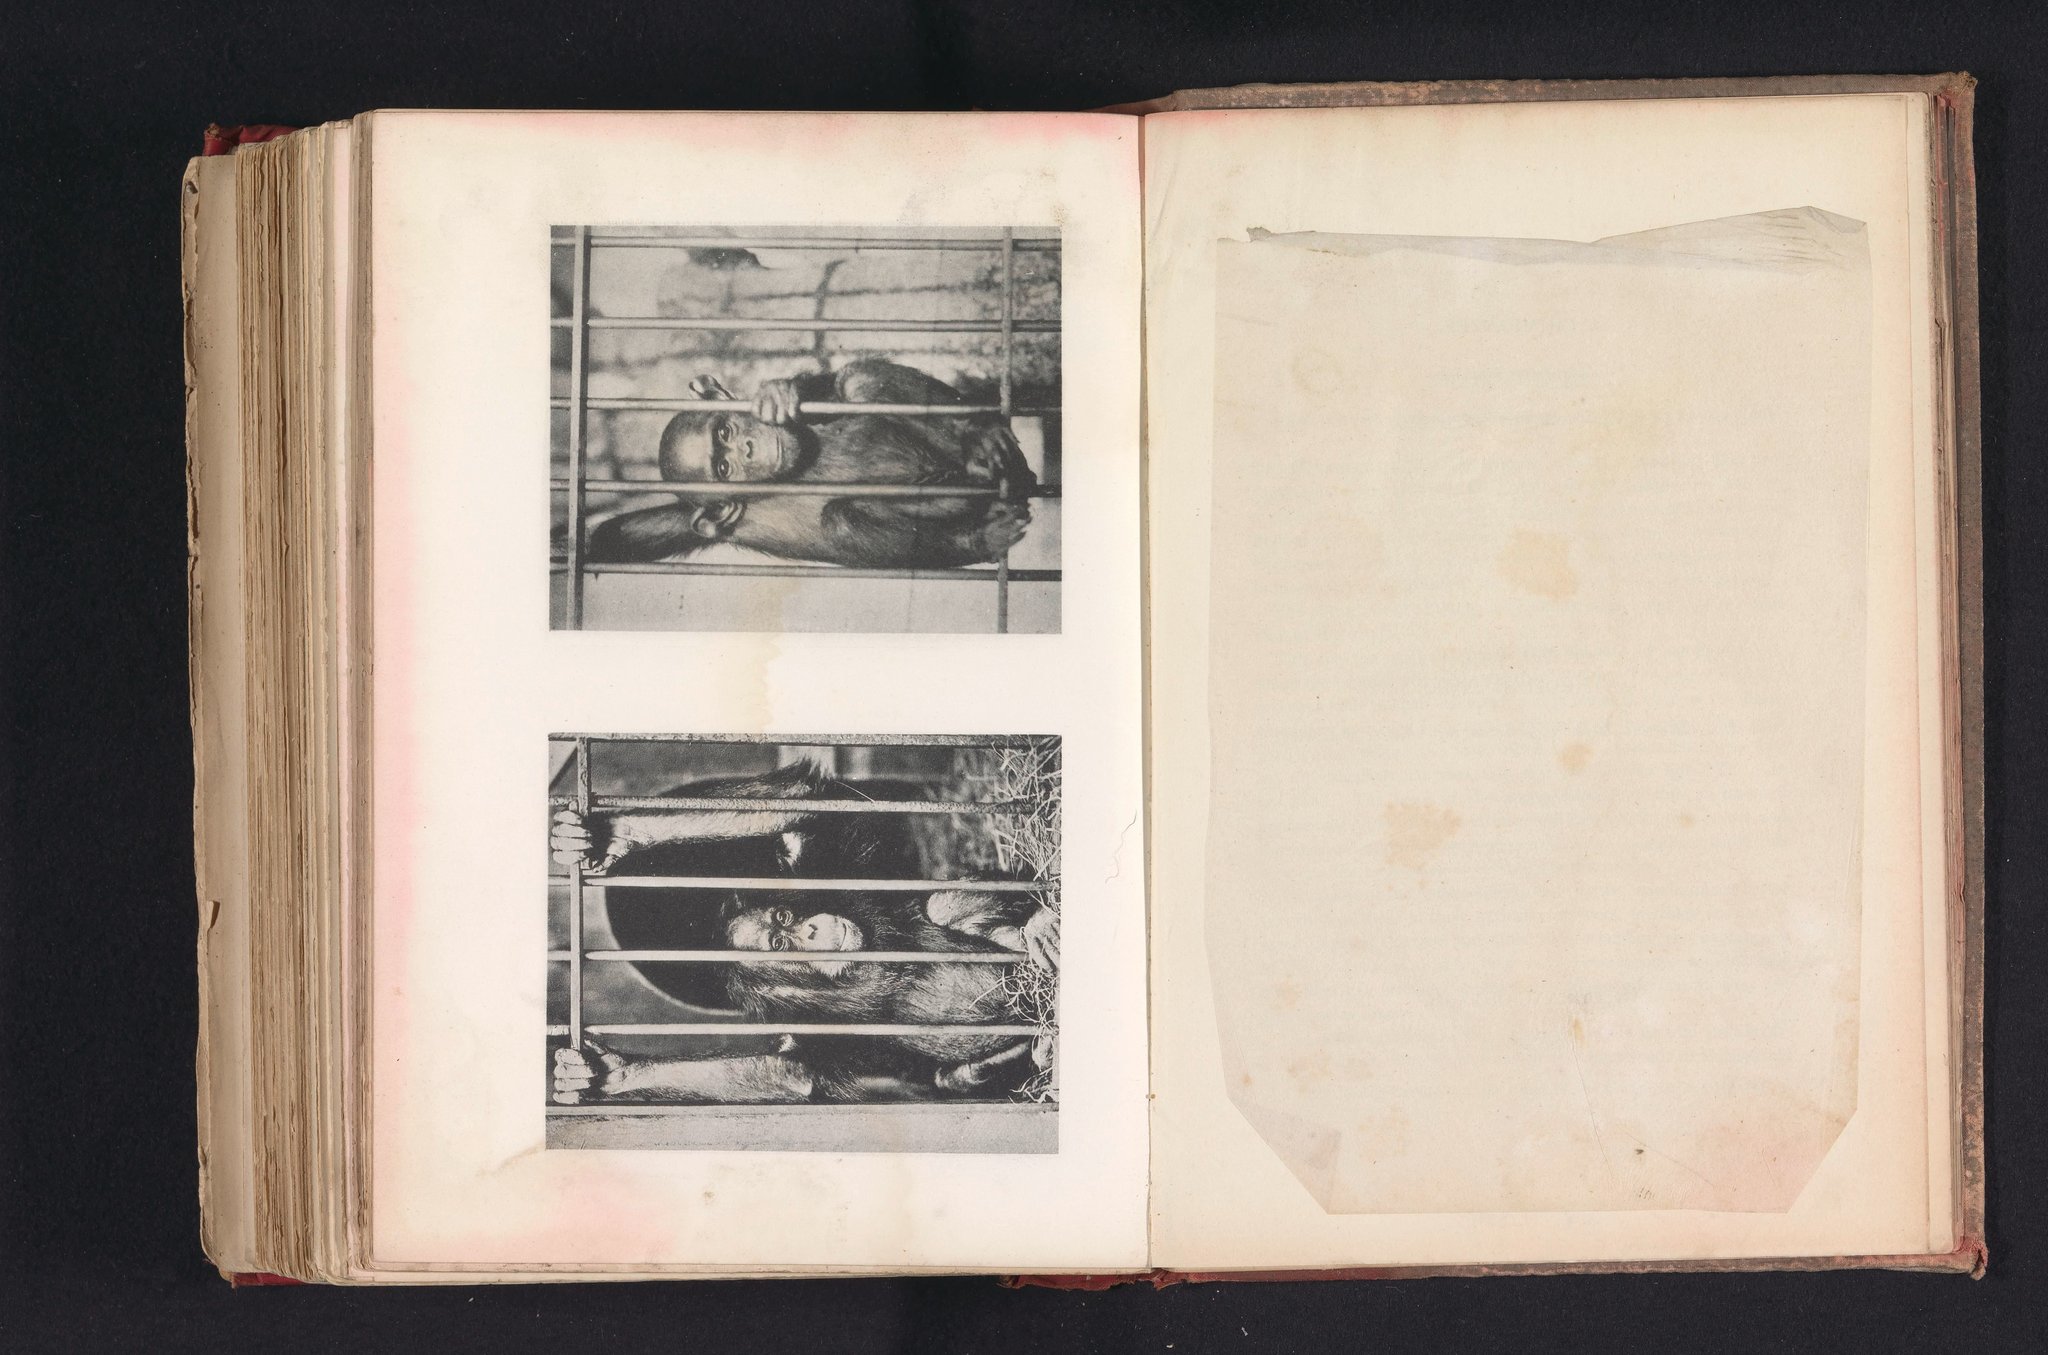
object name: page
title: Anthropoid apes, a chimpanzee, an ourang-outang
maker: Anonymous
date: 1876-1886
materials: paper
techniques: photograph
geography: london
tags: monkeys, apes, zoological garden, zoo, seen as place where non-domestic animals are kept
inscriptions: inscription: ‘This is a photograph of the well-known "Sally" beloning to the Zoological Society.’, inscription: ‘From photographs taken by Messrs. Briggs and Son, High Street, St. John's Wood.’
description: Boven een chimpansee, onder een orang-oetan, beiden in een hok.